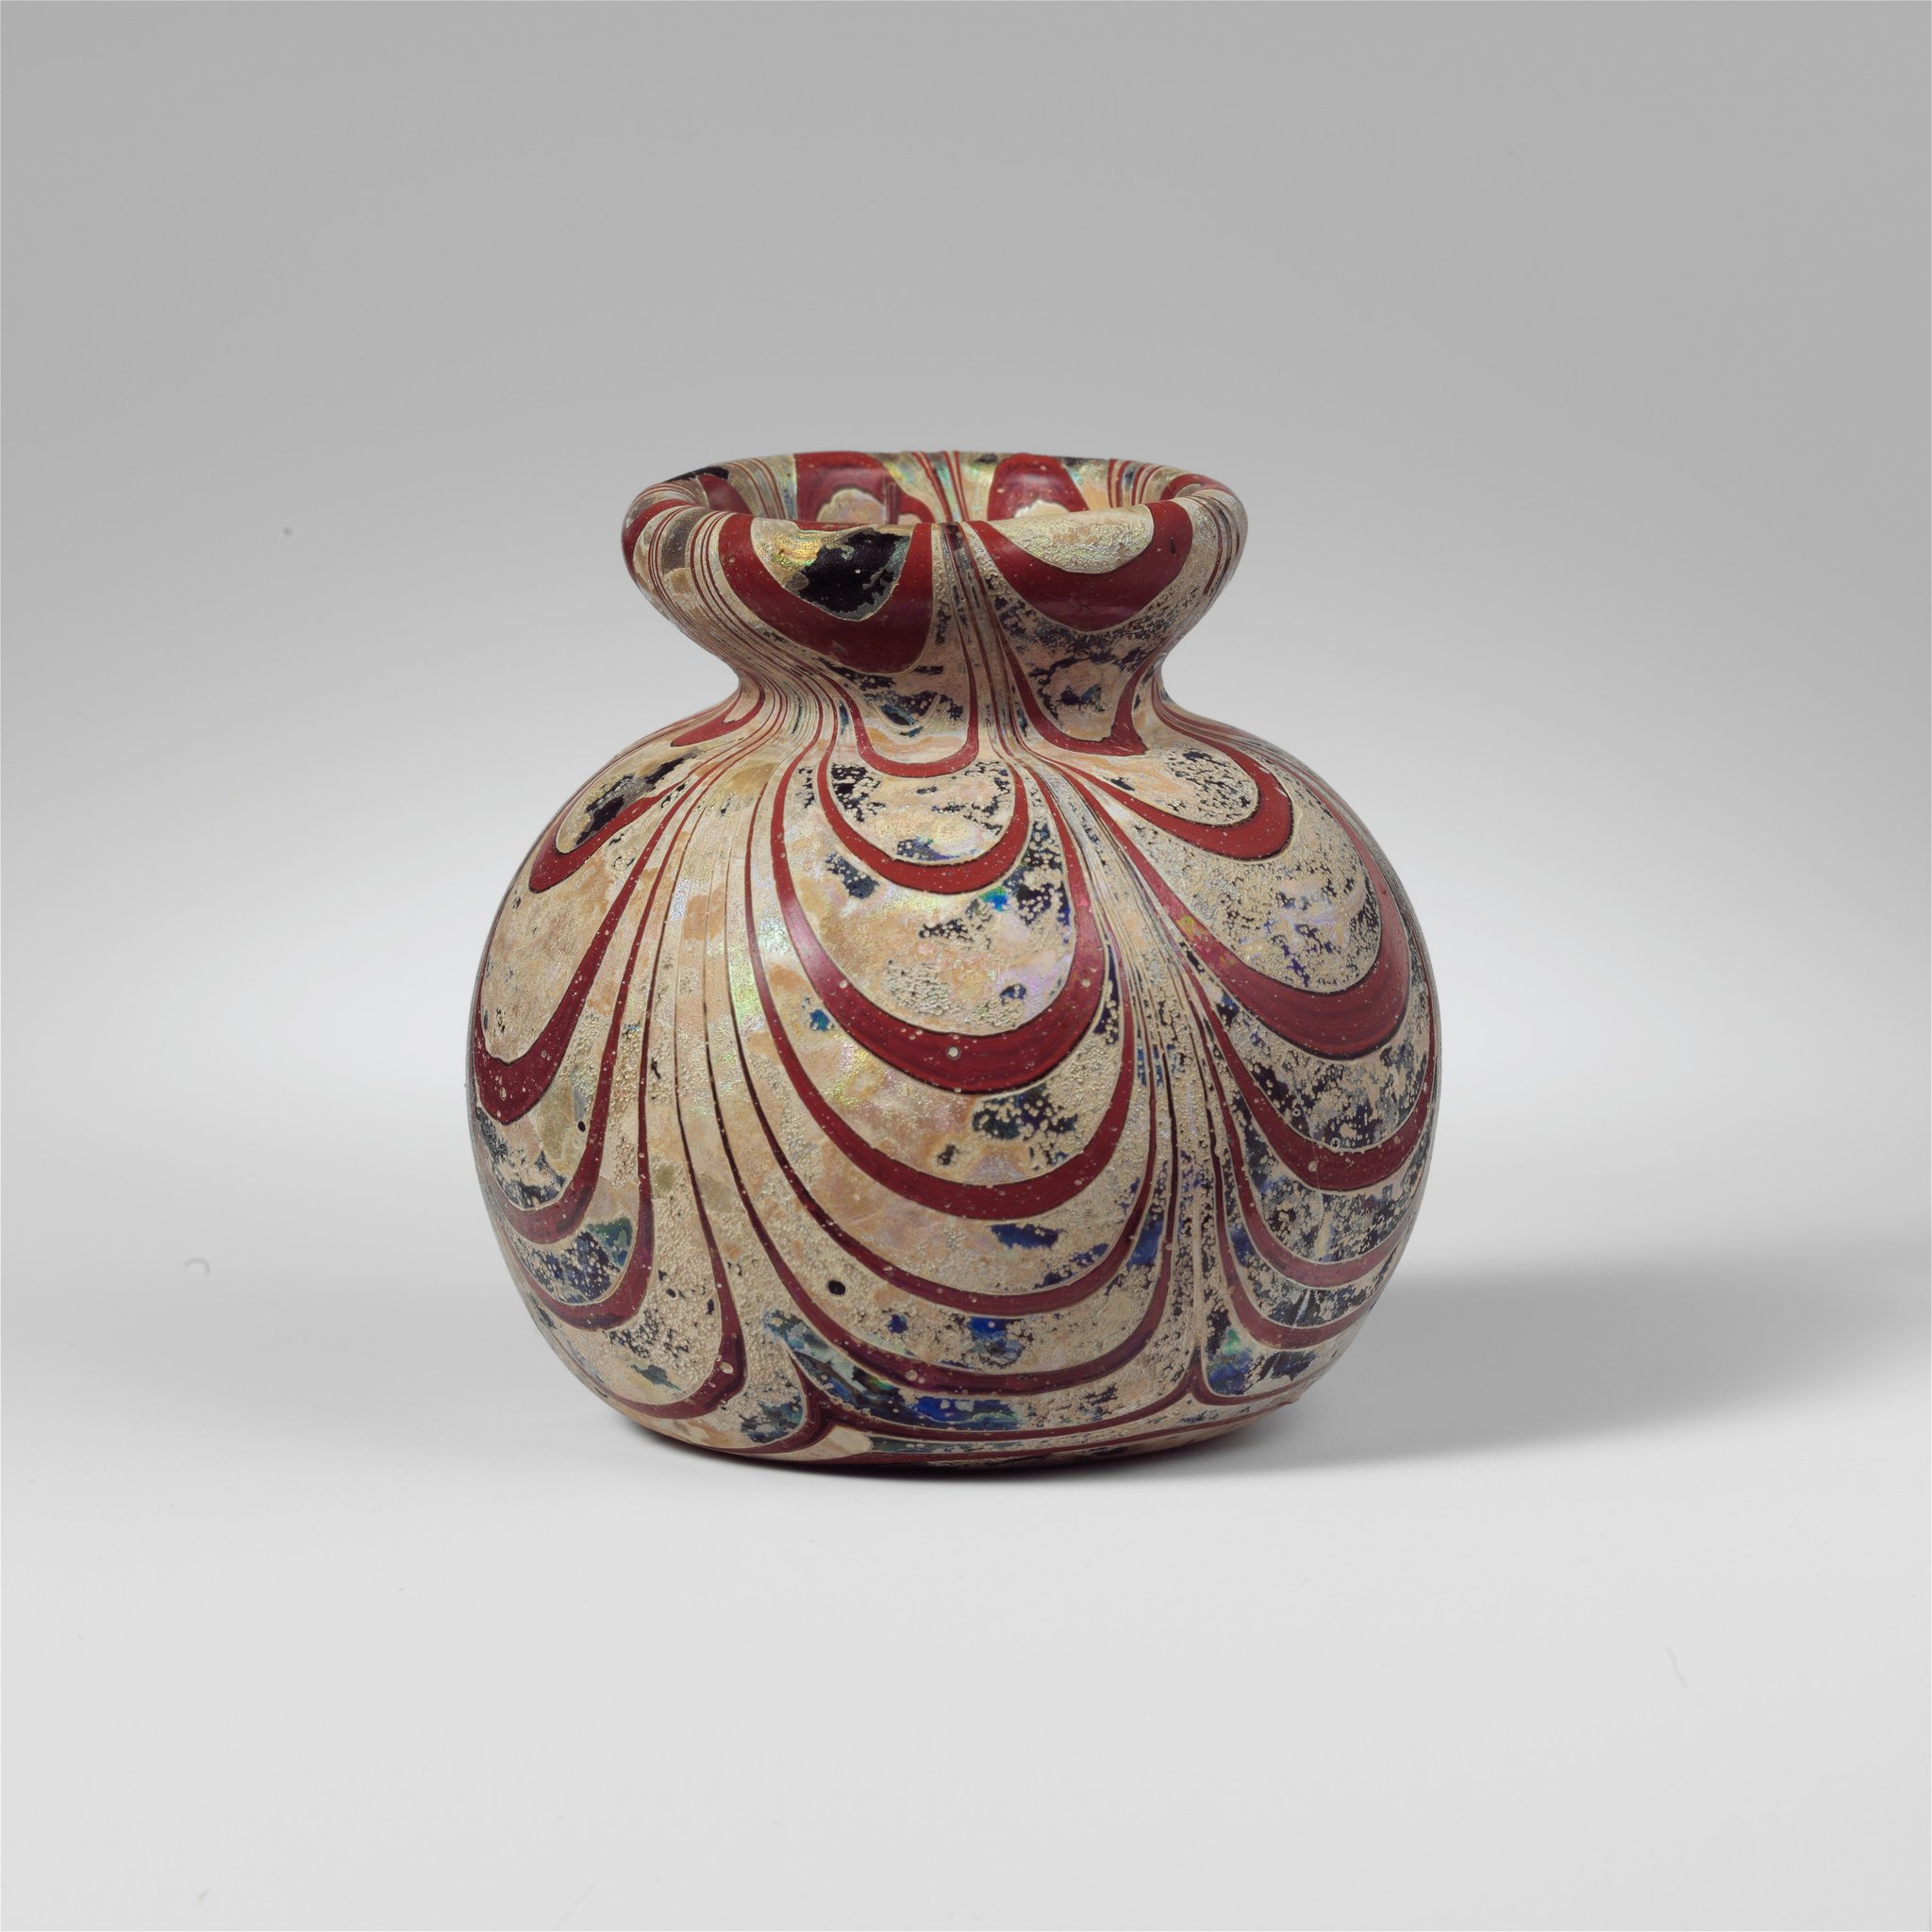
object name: jar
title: Glass jar with marvered trails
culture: roman, syro-palestinian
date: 401-500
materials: glass